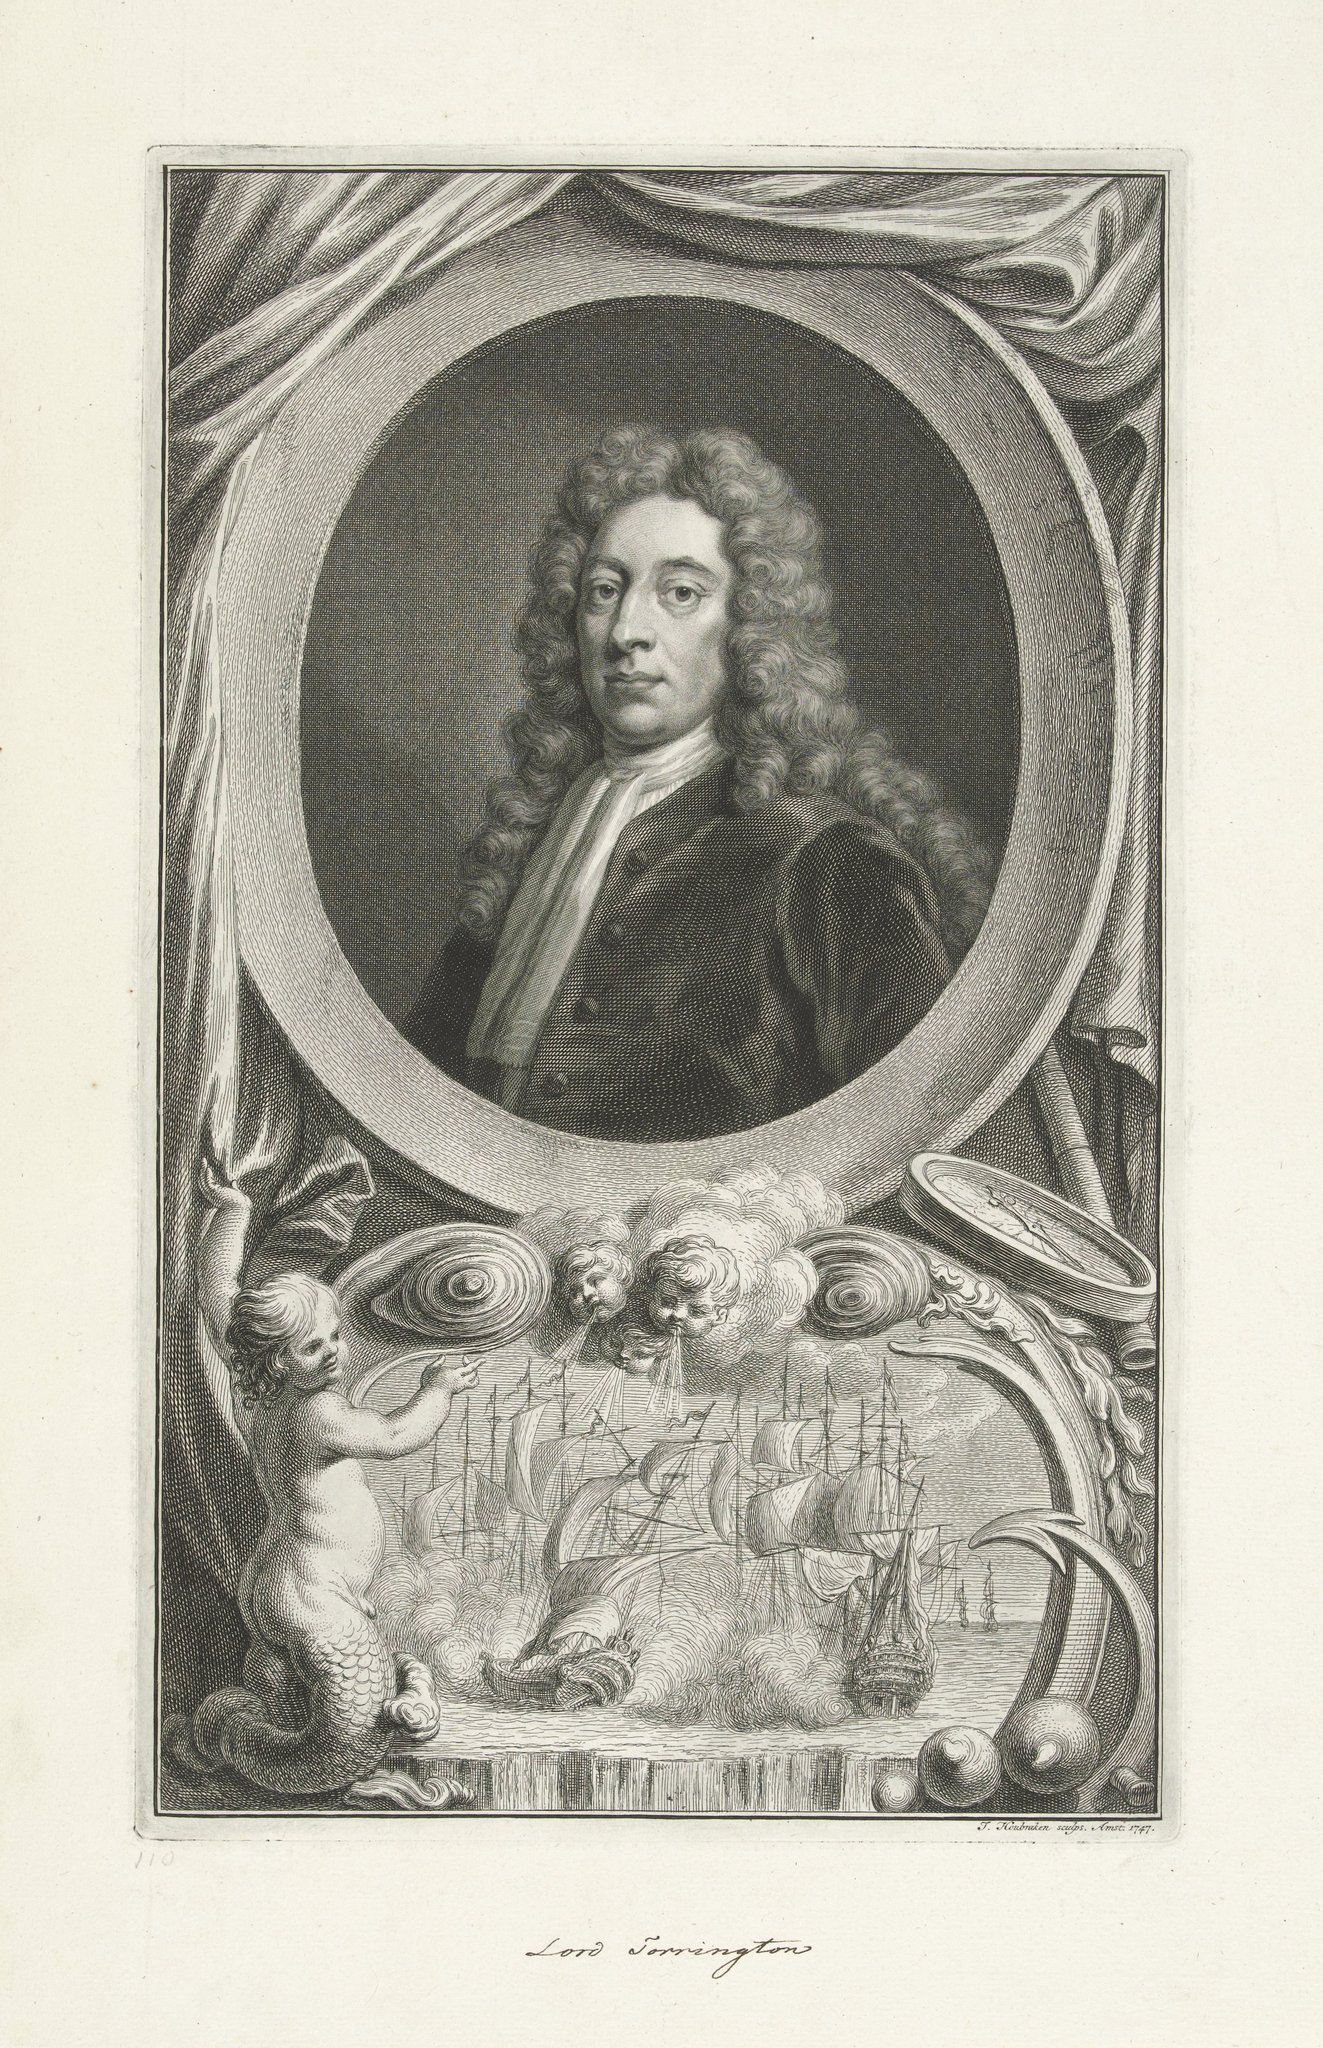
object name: print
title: Portret van George Byng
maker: jacob houbraken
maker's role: draughtsman, print maker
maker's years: 1698-1780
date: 1747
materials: paper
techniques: engraving, etching, pen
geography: amsterdam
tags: zeeofficier, george byng (1e burggraaf van torrington)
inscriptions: name: ‘Lord Torrington’, collector's mark: Lugt 240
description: Portret van de Engelse zee-officier George Byng, 1e burggraaf van Torrington. Onder het portret een cartouche waarbinnen een zeeslag is afgebeeld, omgeven door een jonge triton, drie kinderkopjes tussen wolken die de winden blazen en nautische instrumenten als een kompas en een verrekijker.